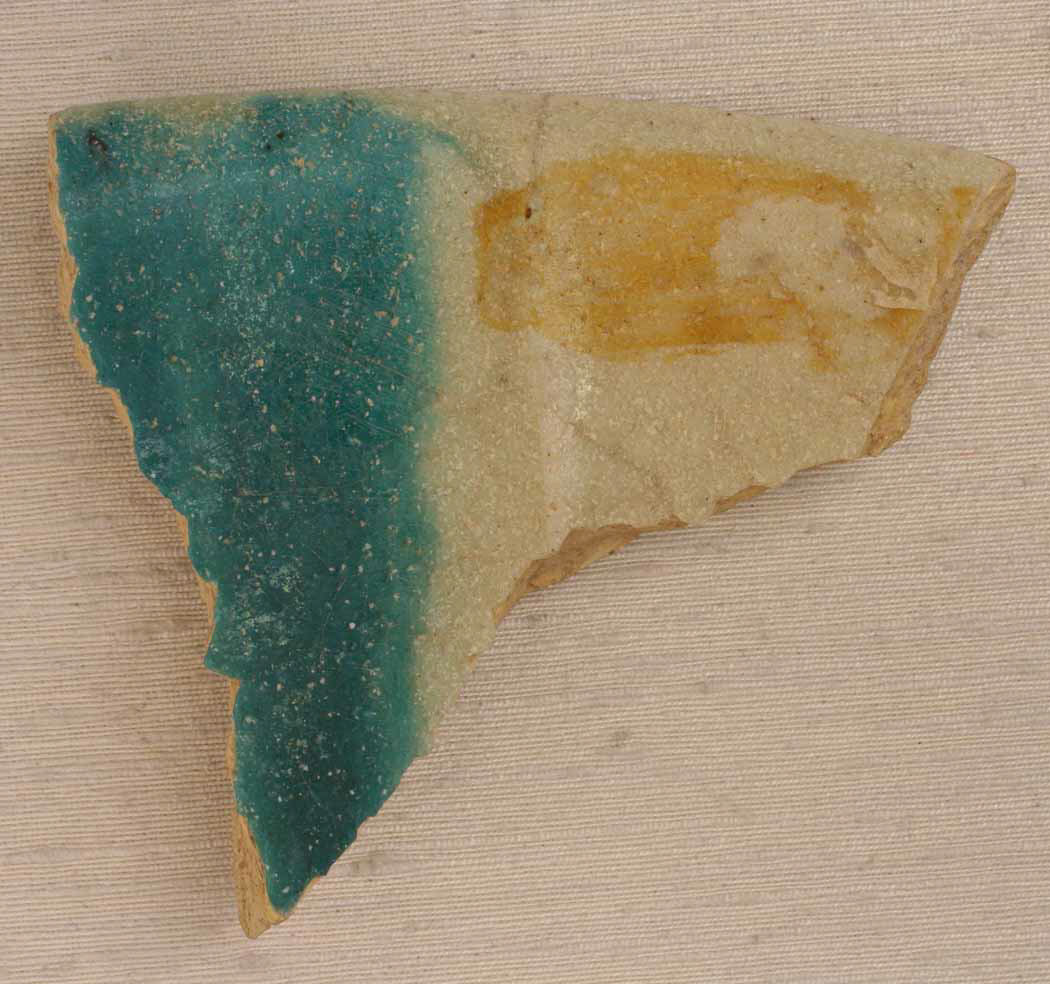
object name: fragment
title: Ceramic Fragment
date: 801-1000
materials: earthenware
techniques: glazing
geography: saudi arabia